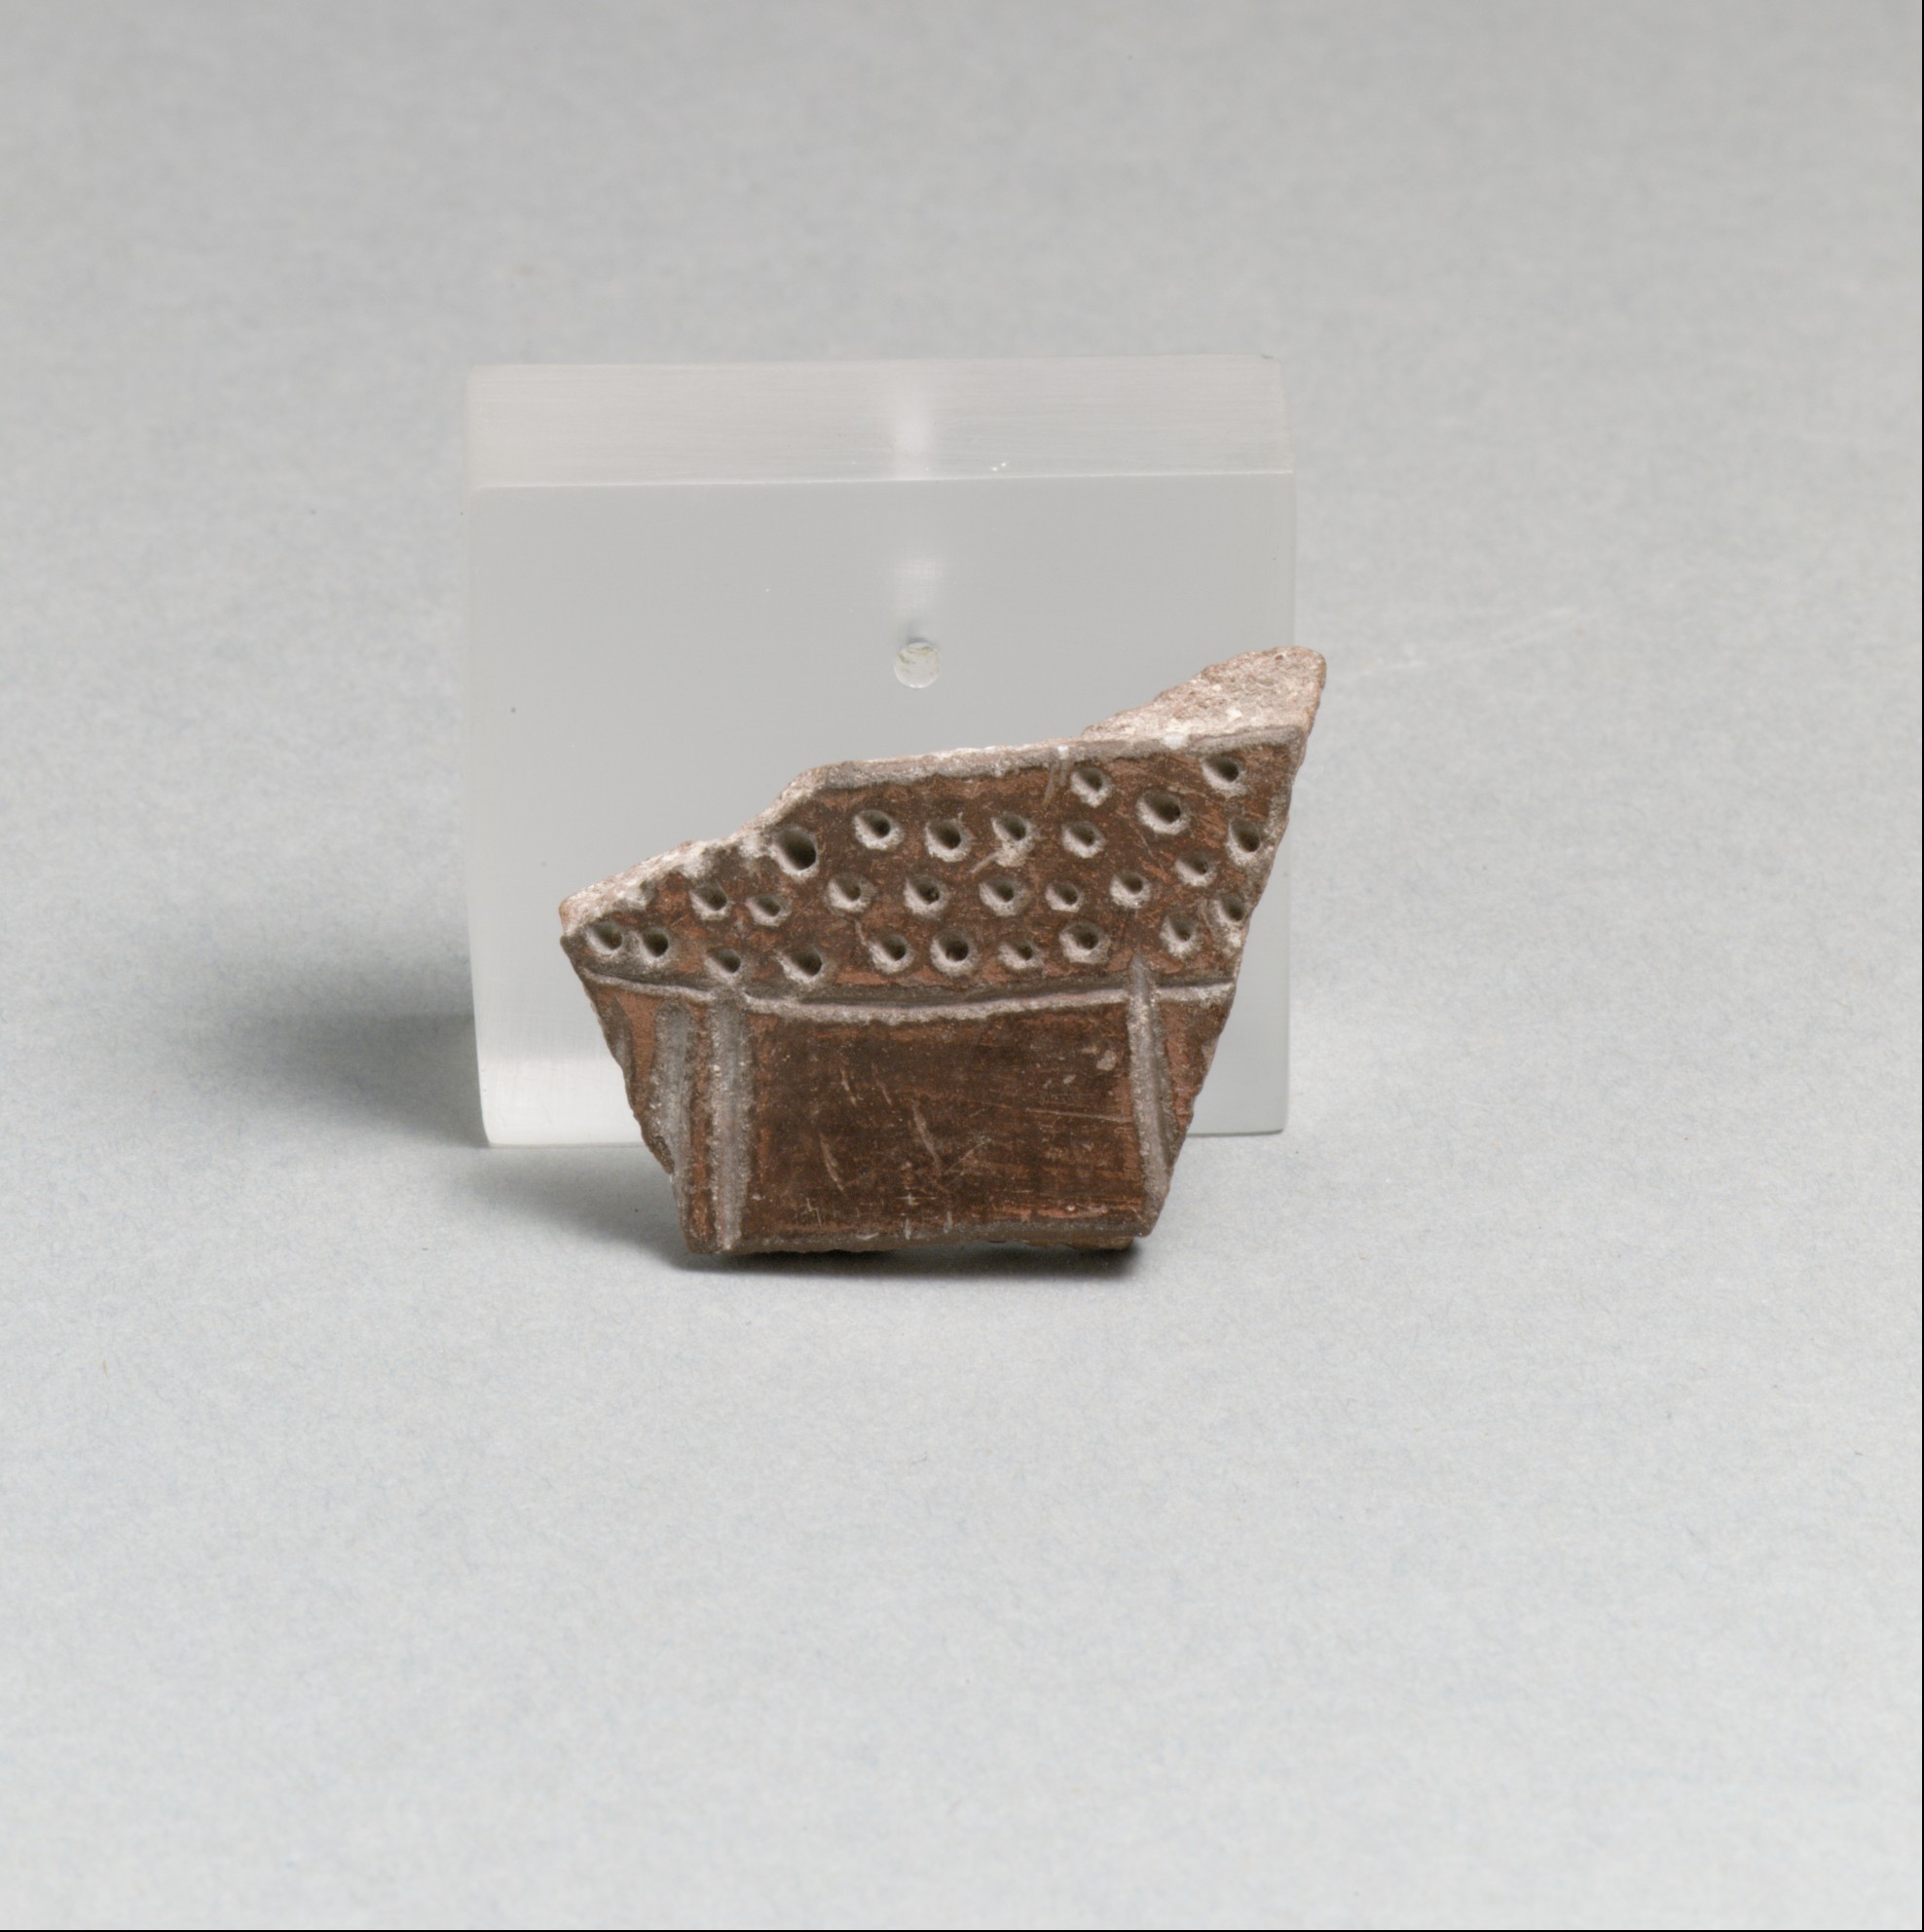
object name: vase fragment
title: Terracotta vessel fragment with incised lines and punctations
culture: cretan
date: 3600-3100 BCE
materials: terracotta